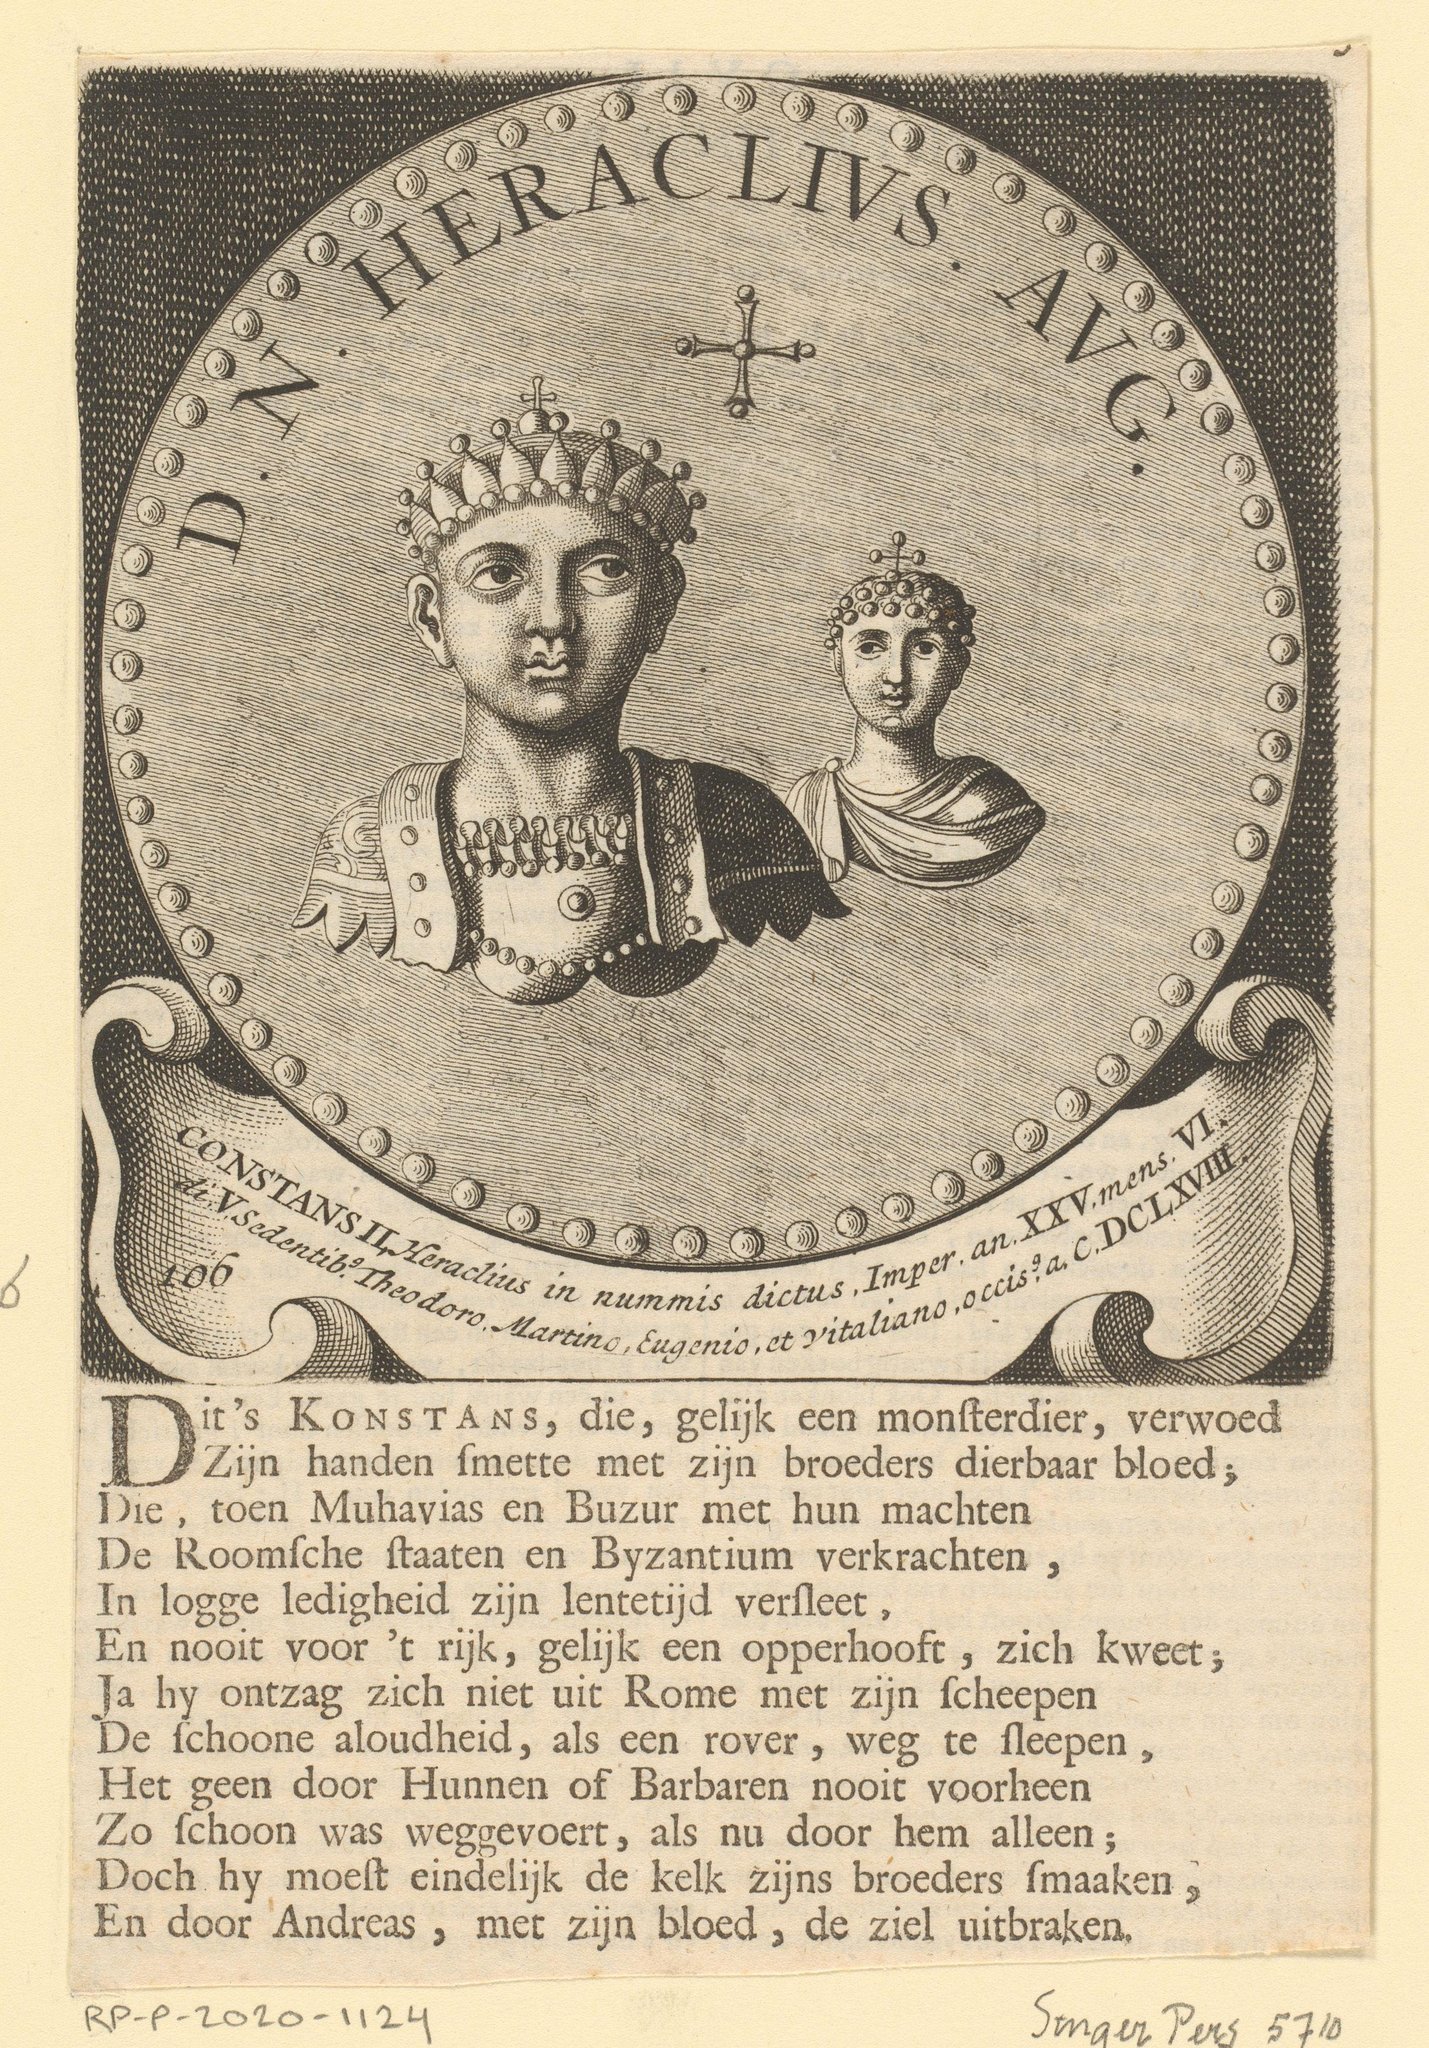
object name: book illustration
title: Portret van keizer Constans II en zijn vader Constantijn III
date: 1697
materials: paper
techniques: engraving, etching, letterpress printing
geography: utrecht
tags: historical persons, emperor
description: Prent uit: Bogaert, Abraham. De Roomsche monarchy, vertoont in de muntbeelden der westersche en oostersche keizeren (...). Utrecht: François Halma en Willem van de Water, 1697, p. 319. Eerste staat verschenen in een grotere prent met twaalf portretten, gedateerd 1695.